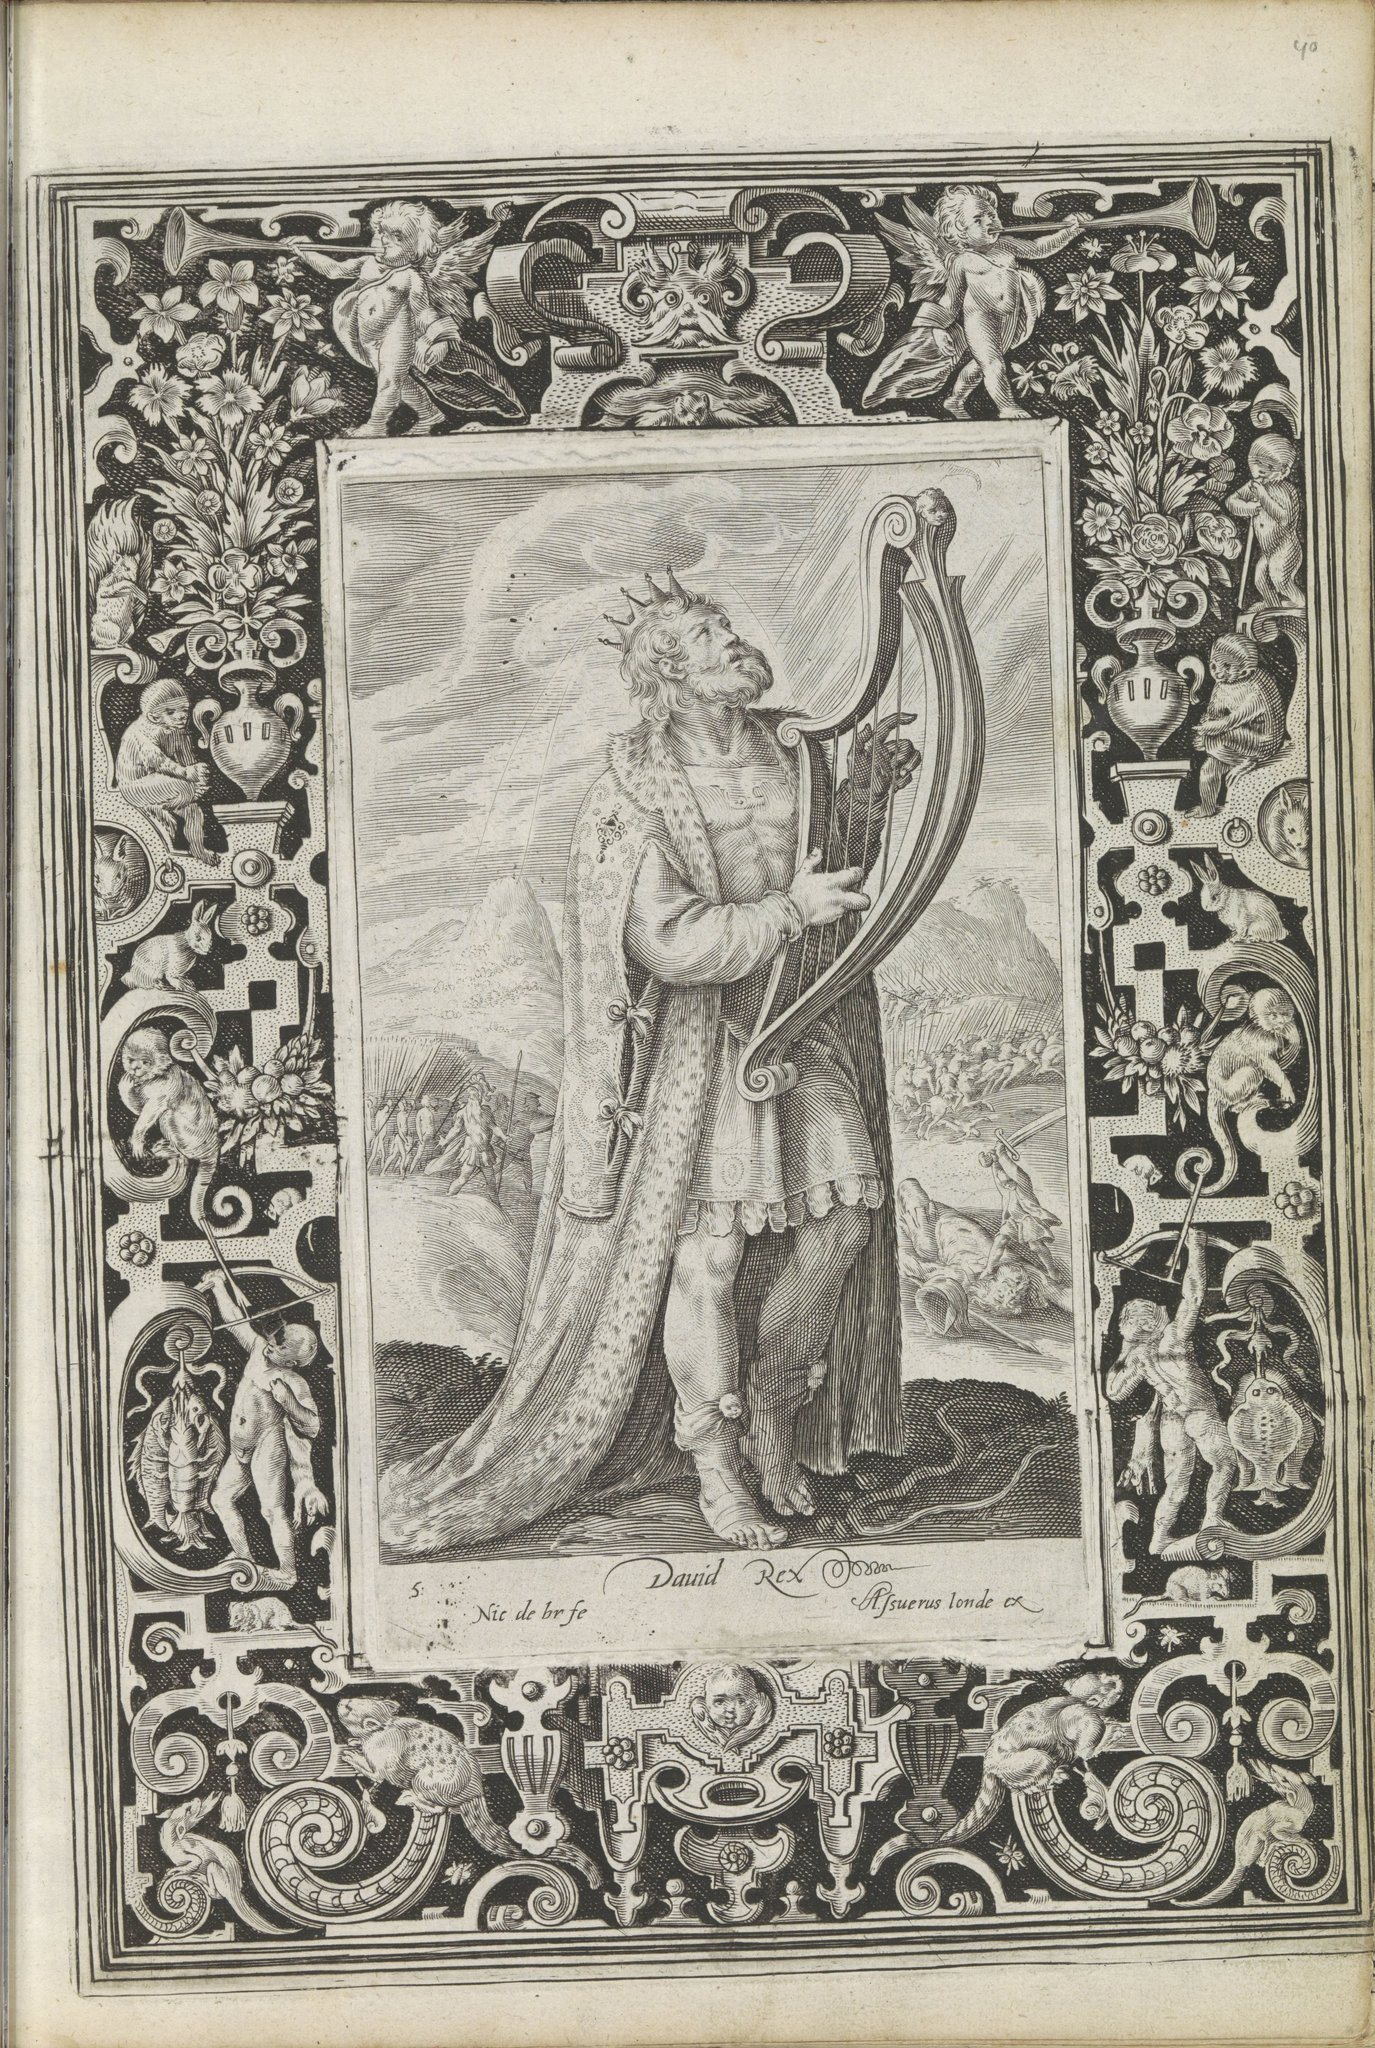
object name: print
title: David Rex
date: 1582-1635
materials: paper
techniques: engraving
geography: low countries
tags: frequently used ornamental compositions, david (one of the nine worthies)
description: Koning David, een beroemde veldheer uit het Oude Testament, bespeelt de harp in een landschap. Hij maakt deel uit van De Negen Besten. Op de achtergond zijn overwinning op Goliat. Onder de voorstelling een vers in het Latijn. De voorstelling is gevat in een omlijsting met krulornamenten en verschillende dieren zoals een kat die naar een muis loert, apen en konijnen waarop twee jongens jagen. Deze prent maakt deel uit van een album.